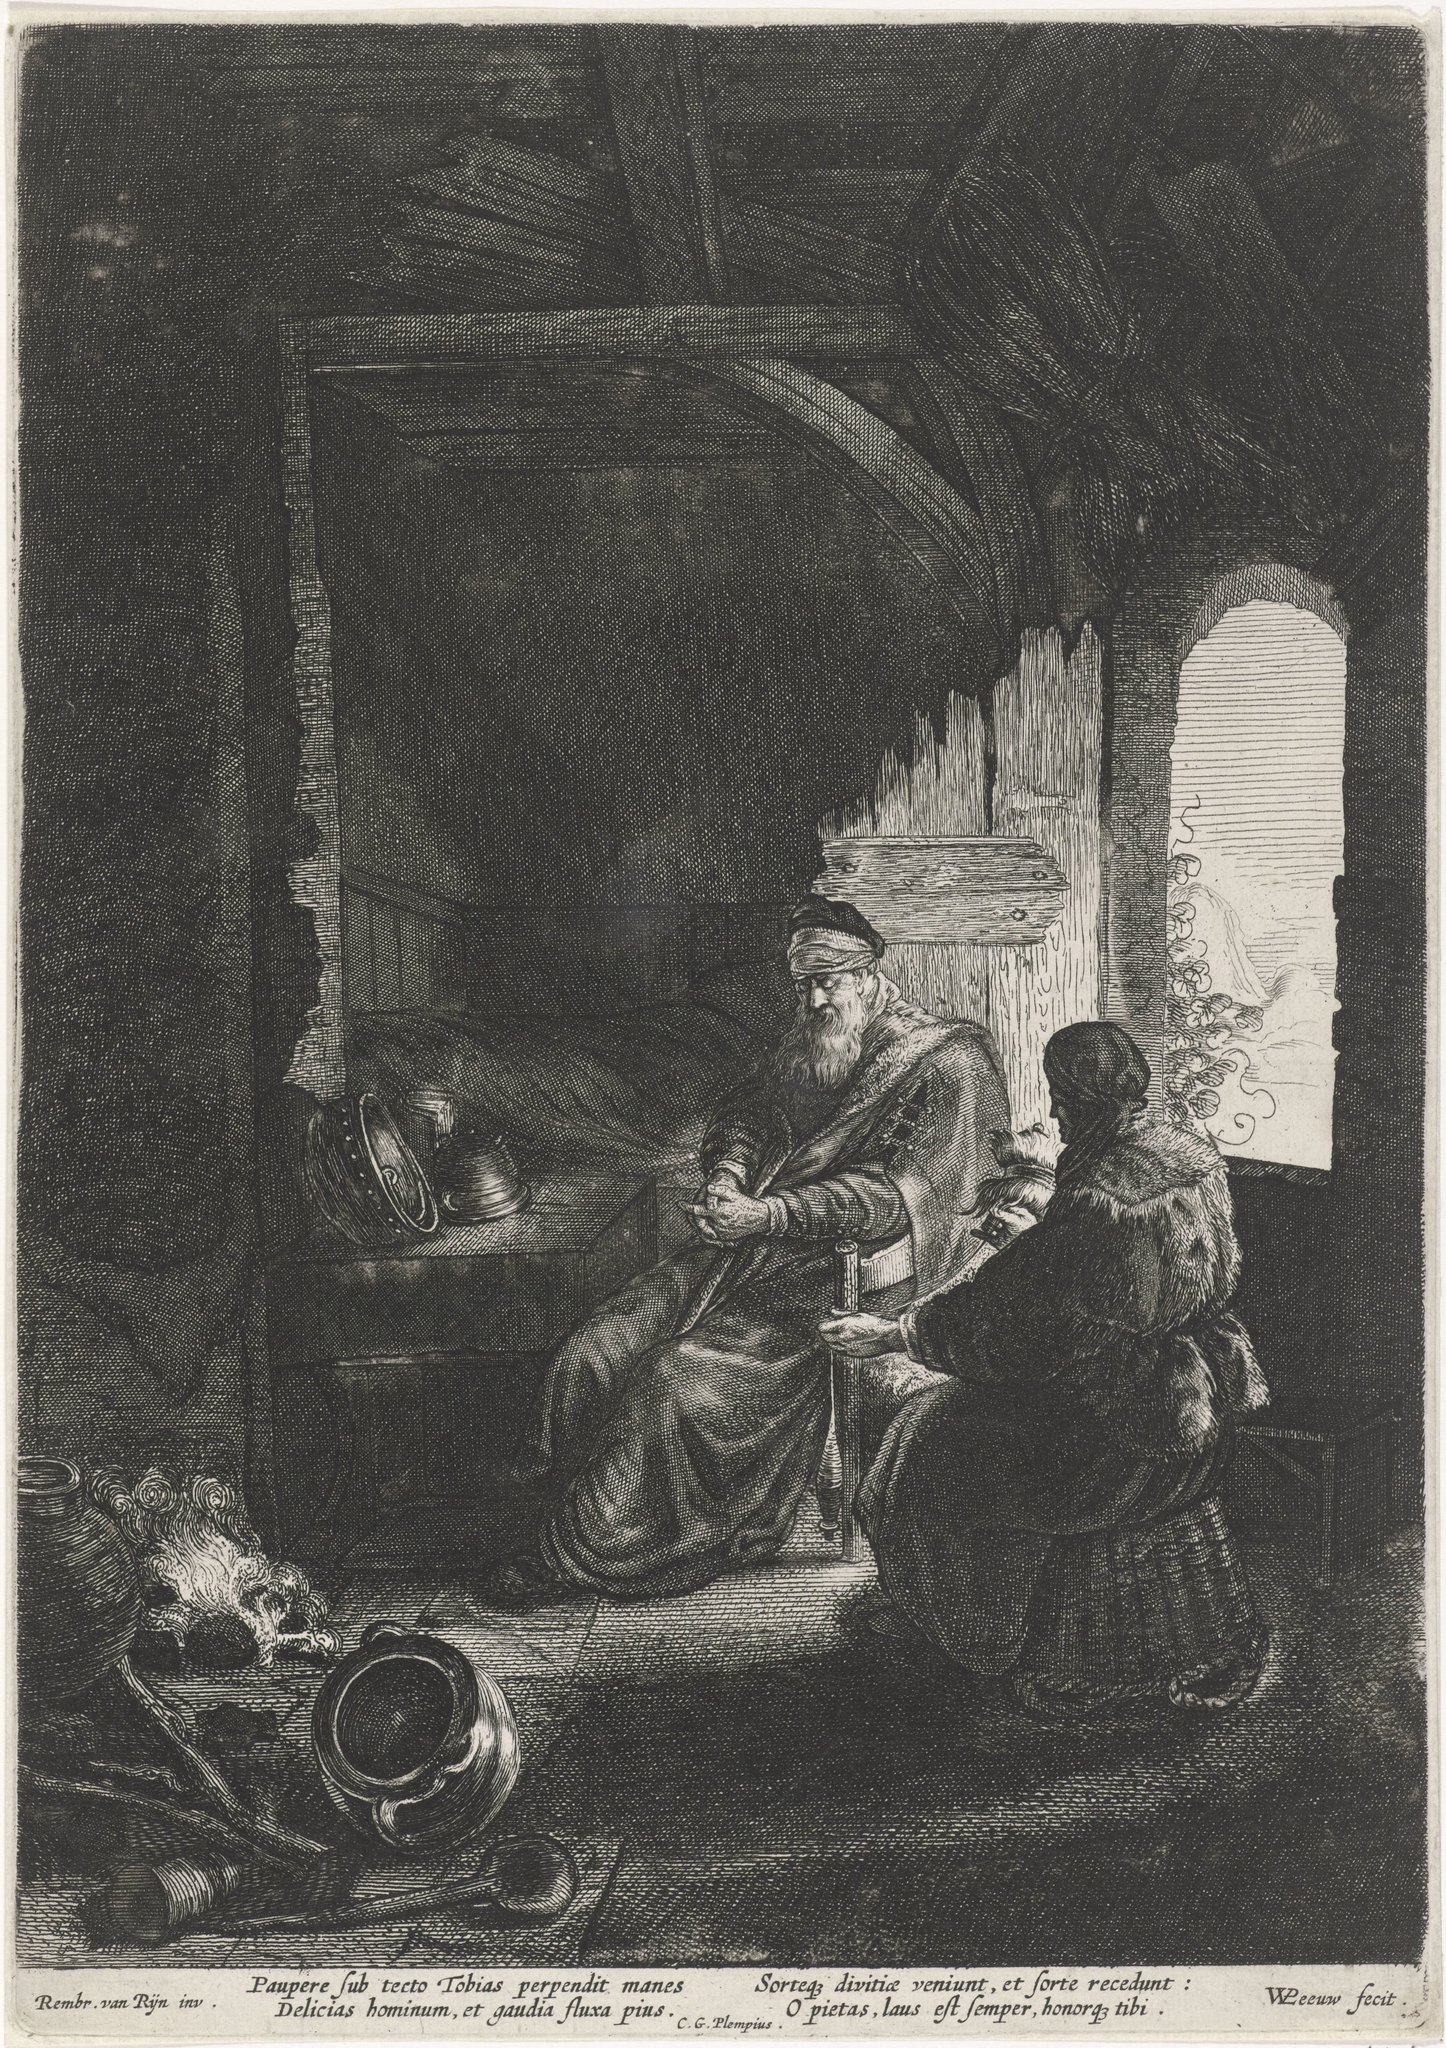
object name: print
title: Tobit en zijn vrouw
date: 1616-1665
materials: paper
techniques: engraving, etching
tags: old tobit (and anna) waiting and worrying about the long absence of their son; sometimes anna is shown at the spinning-wheel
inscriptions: collector's mark: Lugt 240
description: De blinde Tobit en zijn vrouw Anna in een interieur. Tobit slaapt op een stoel voor een bedstee, Anna zit op een mand wol te spinnen. In de marge een vierregelig vers in het Latijn.